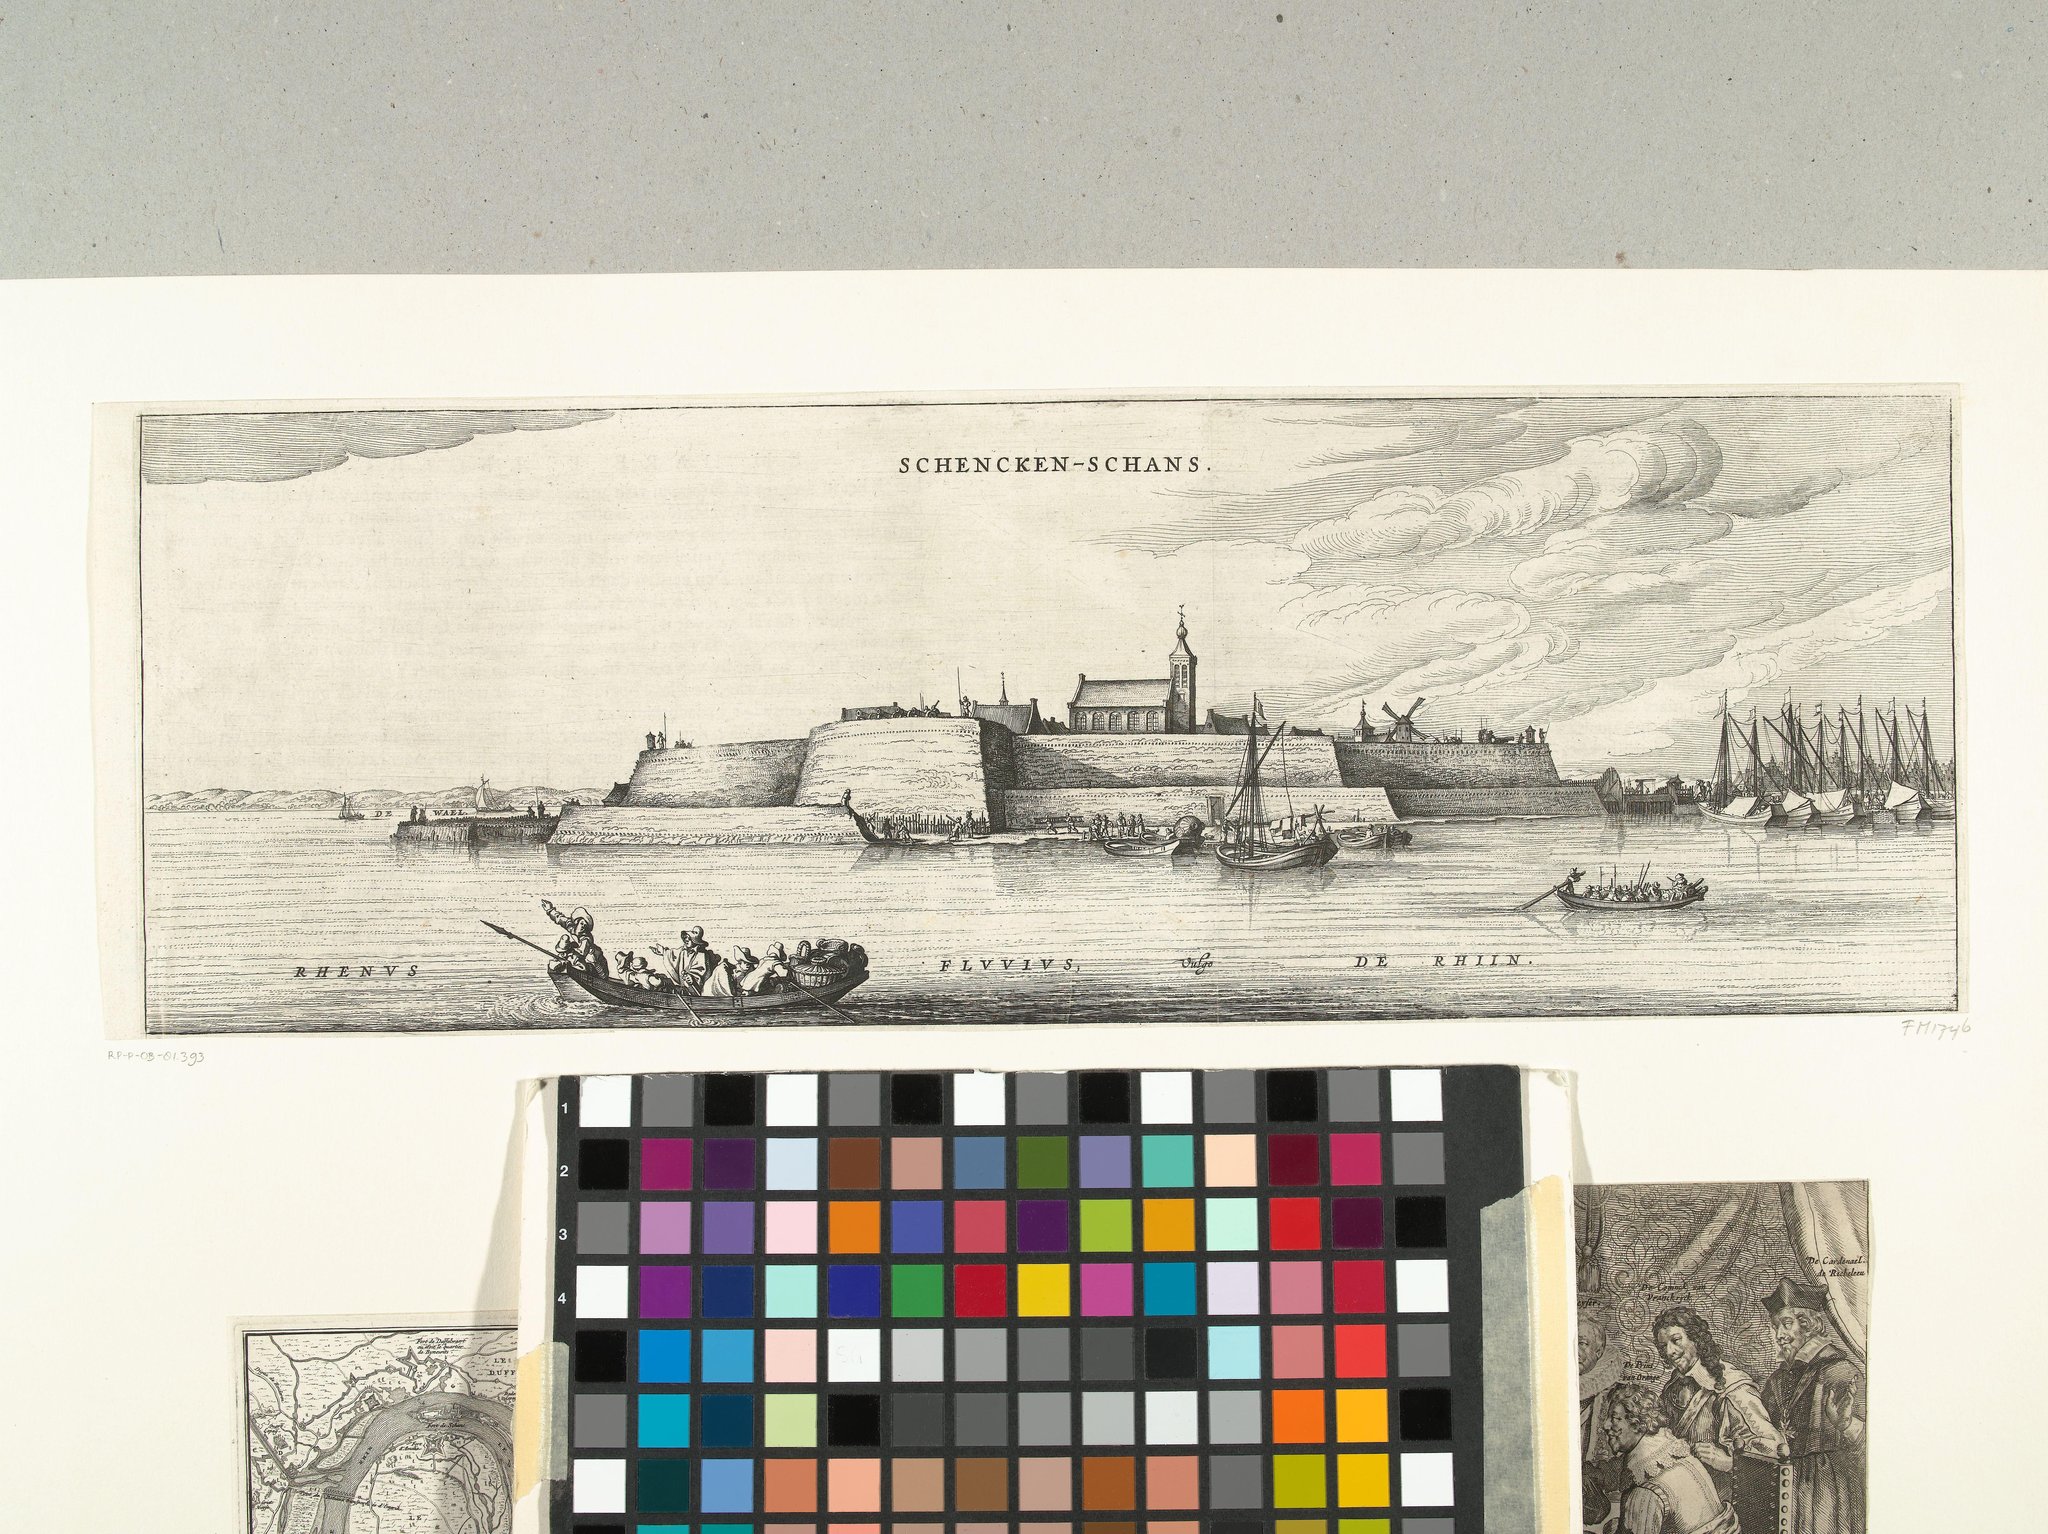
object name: print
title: Schencken-Schans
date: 1647-1649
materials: paper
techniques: etching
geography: northern netherlands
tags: delft, the hague, frederick henry (prince of orange), fortifications, military engineering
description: Gezicht op Schenckenschans vanaf de Rijn, in het water enkele bootjes. Het fort is belegerd en ingenomen door het Staatse leger onder Frederik Hendrik, 1635-1636. Deel van een dubbelpagina genomen uit het Stedenboek van Blaeu. Bedrukt op achterzijde met tekst in het Nederlands.